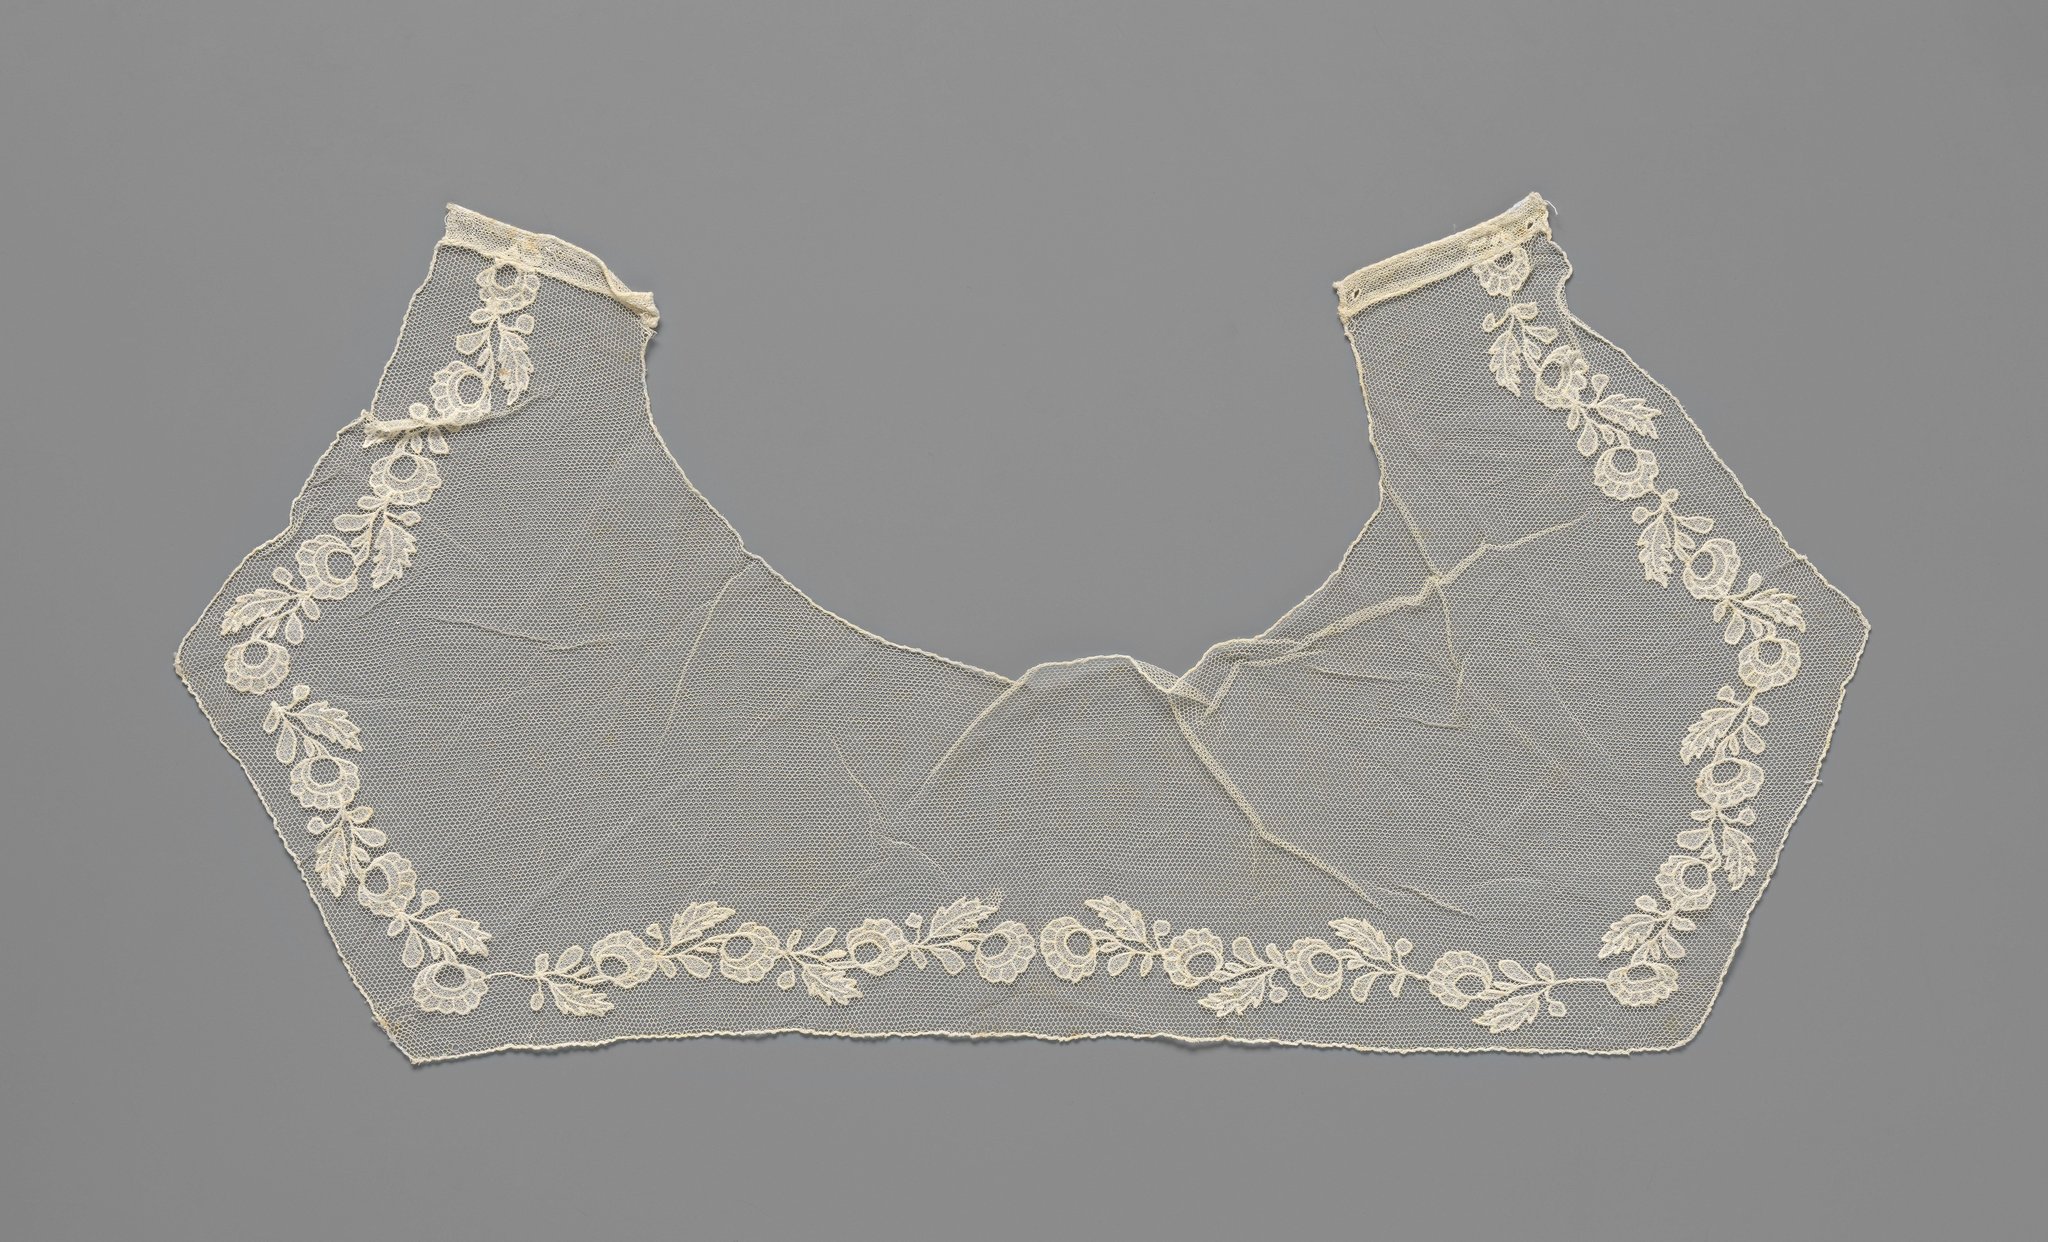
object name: collar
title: Kraag van applicatiekant met een rij liggende bloem- en bladmotieven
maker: Anonymous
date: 1900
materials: textile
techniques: lace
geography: europe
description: Kraag van naturelkleurige applicatiekant: machinale tule waarop motieven zijn geappliceerd van batist. Langs de rand heeft het patroon een rij liggende bloem- en bladmotieven.